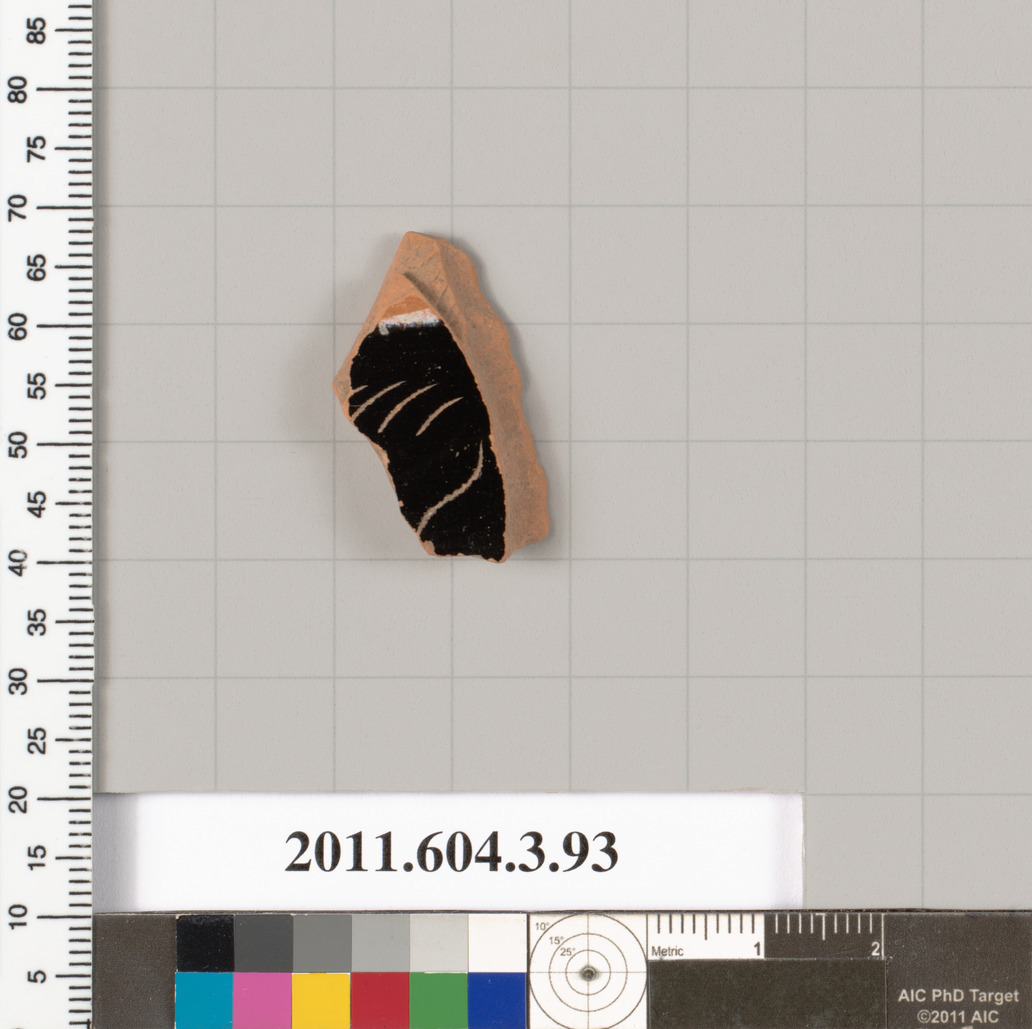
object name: amphora fragment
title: Terracotta fragment of an amphora (jar)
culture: greek, attic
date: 550-501 BCE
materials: terracotta